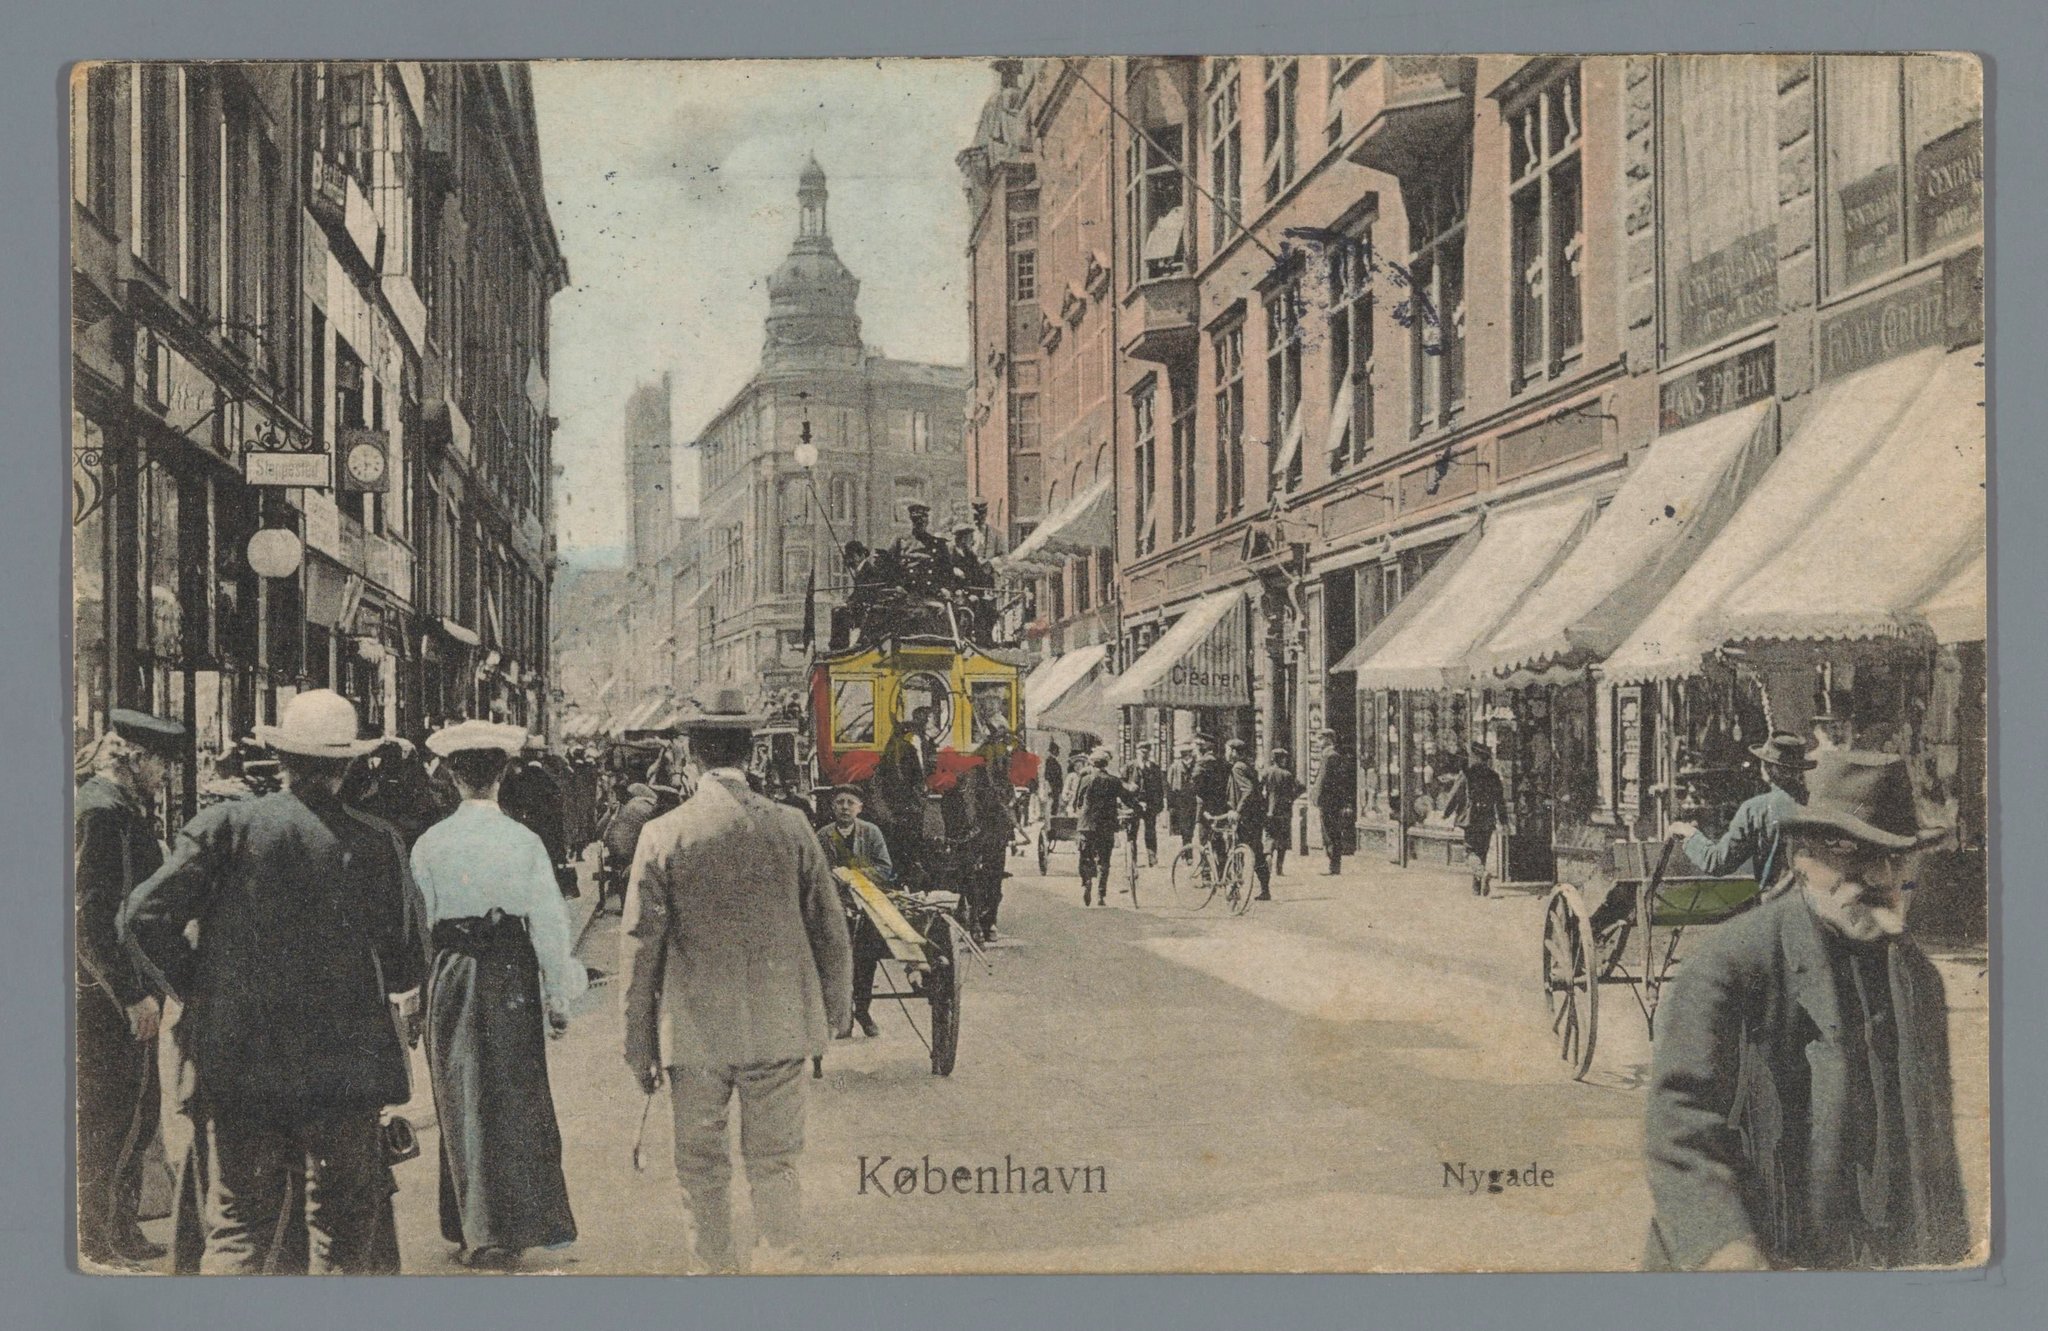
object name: ansichtkaart, prentbriefkaart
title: Kobenhavn, Nygade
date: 1909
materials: cardboard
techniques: photograph, hand coloring, writing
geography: copenhagen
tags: street, copenhagen (city)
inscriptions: number: ‘Eneret No. 554’